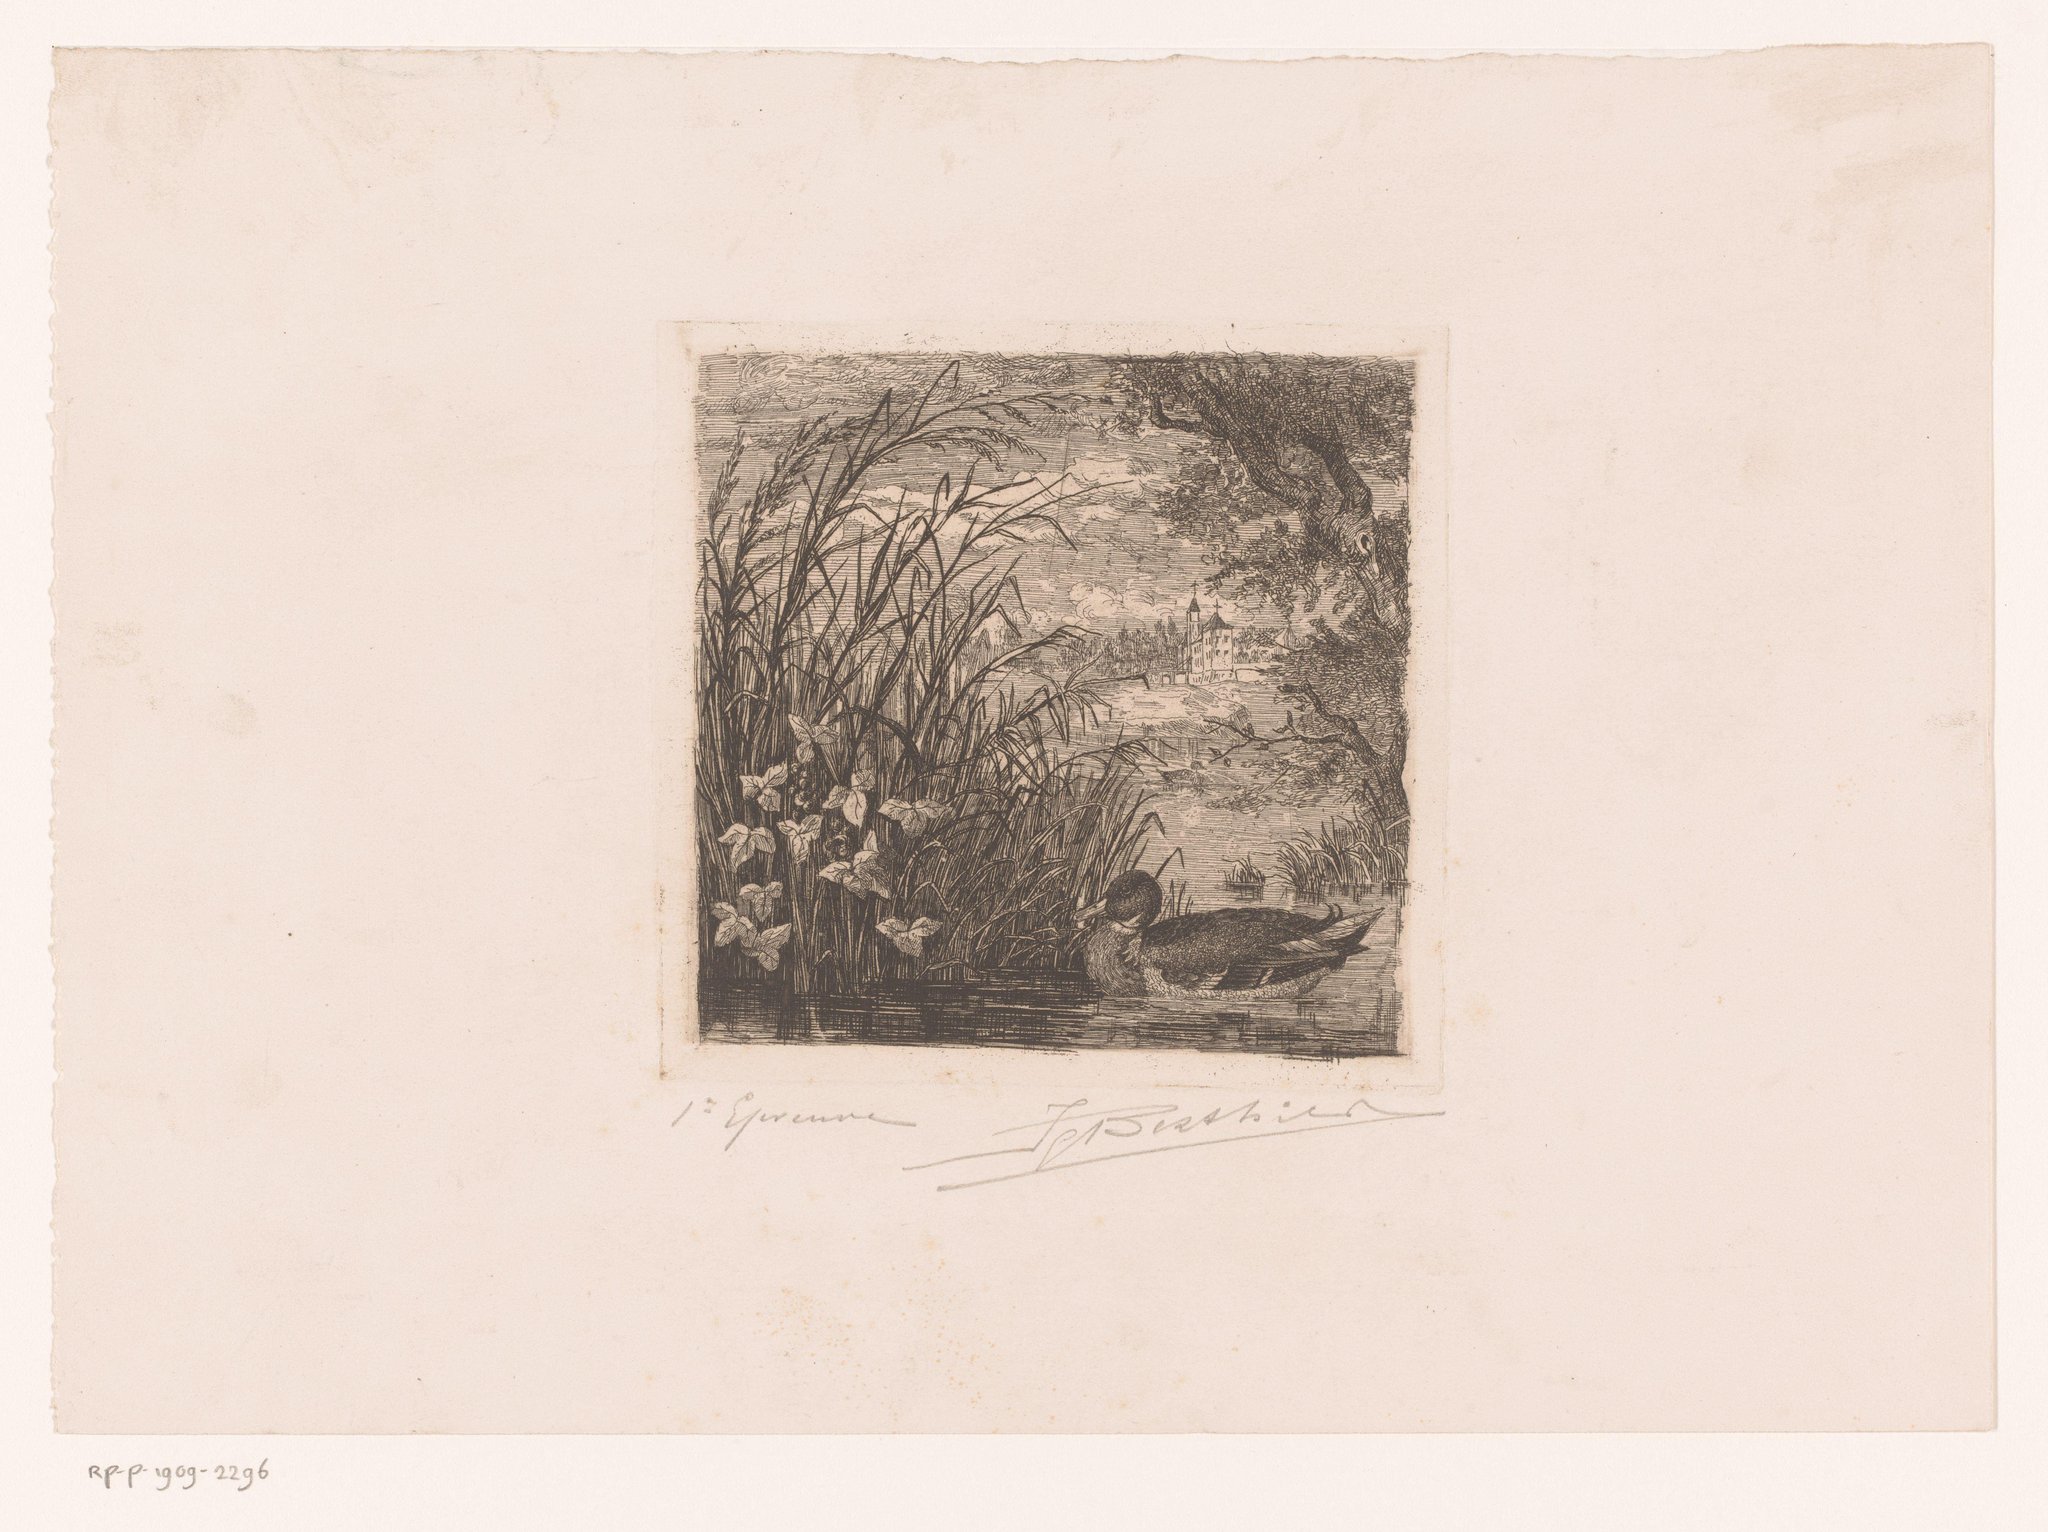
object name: print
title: Eend in een plas met op de achtergrond een kasteel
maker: h. berthier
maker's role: print maker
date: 1870-1909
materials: paper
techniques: etching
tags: landscape with tower or castle, water-birds: duck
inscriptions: collector's mark, inscription: ‘1e Epreuve’